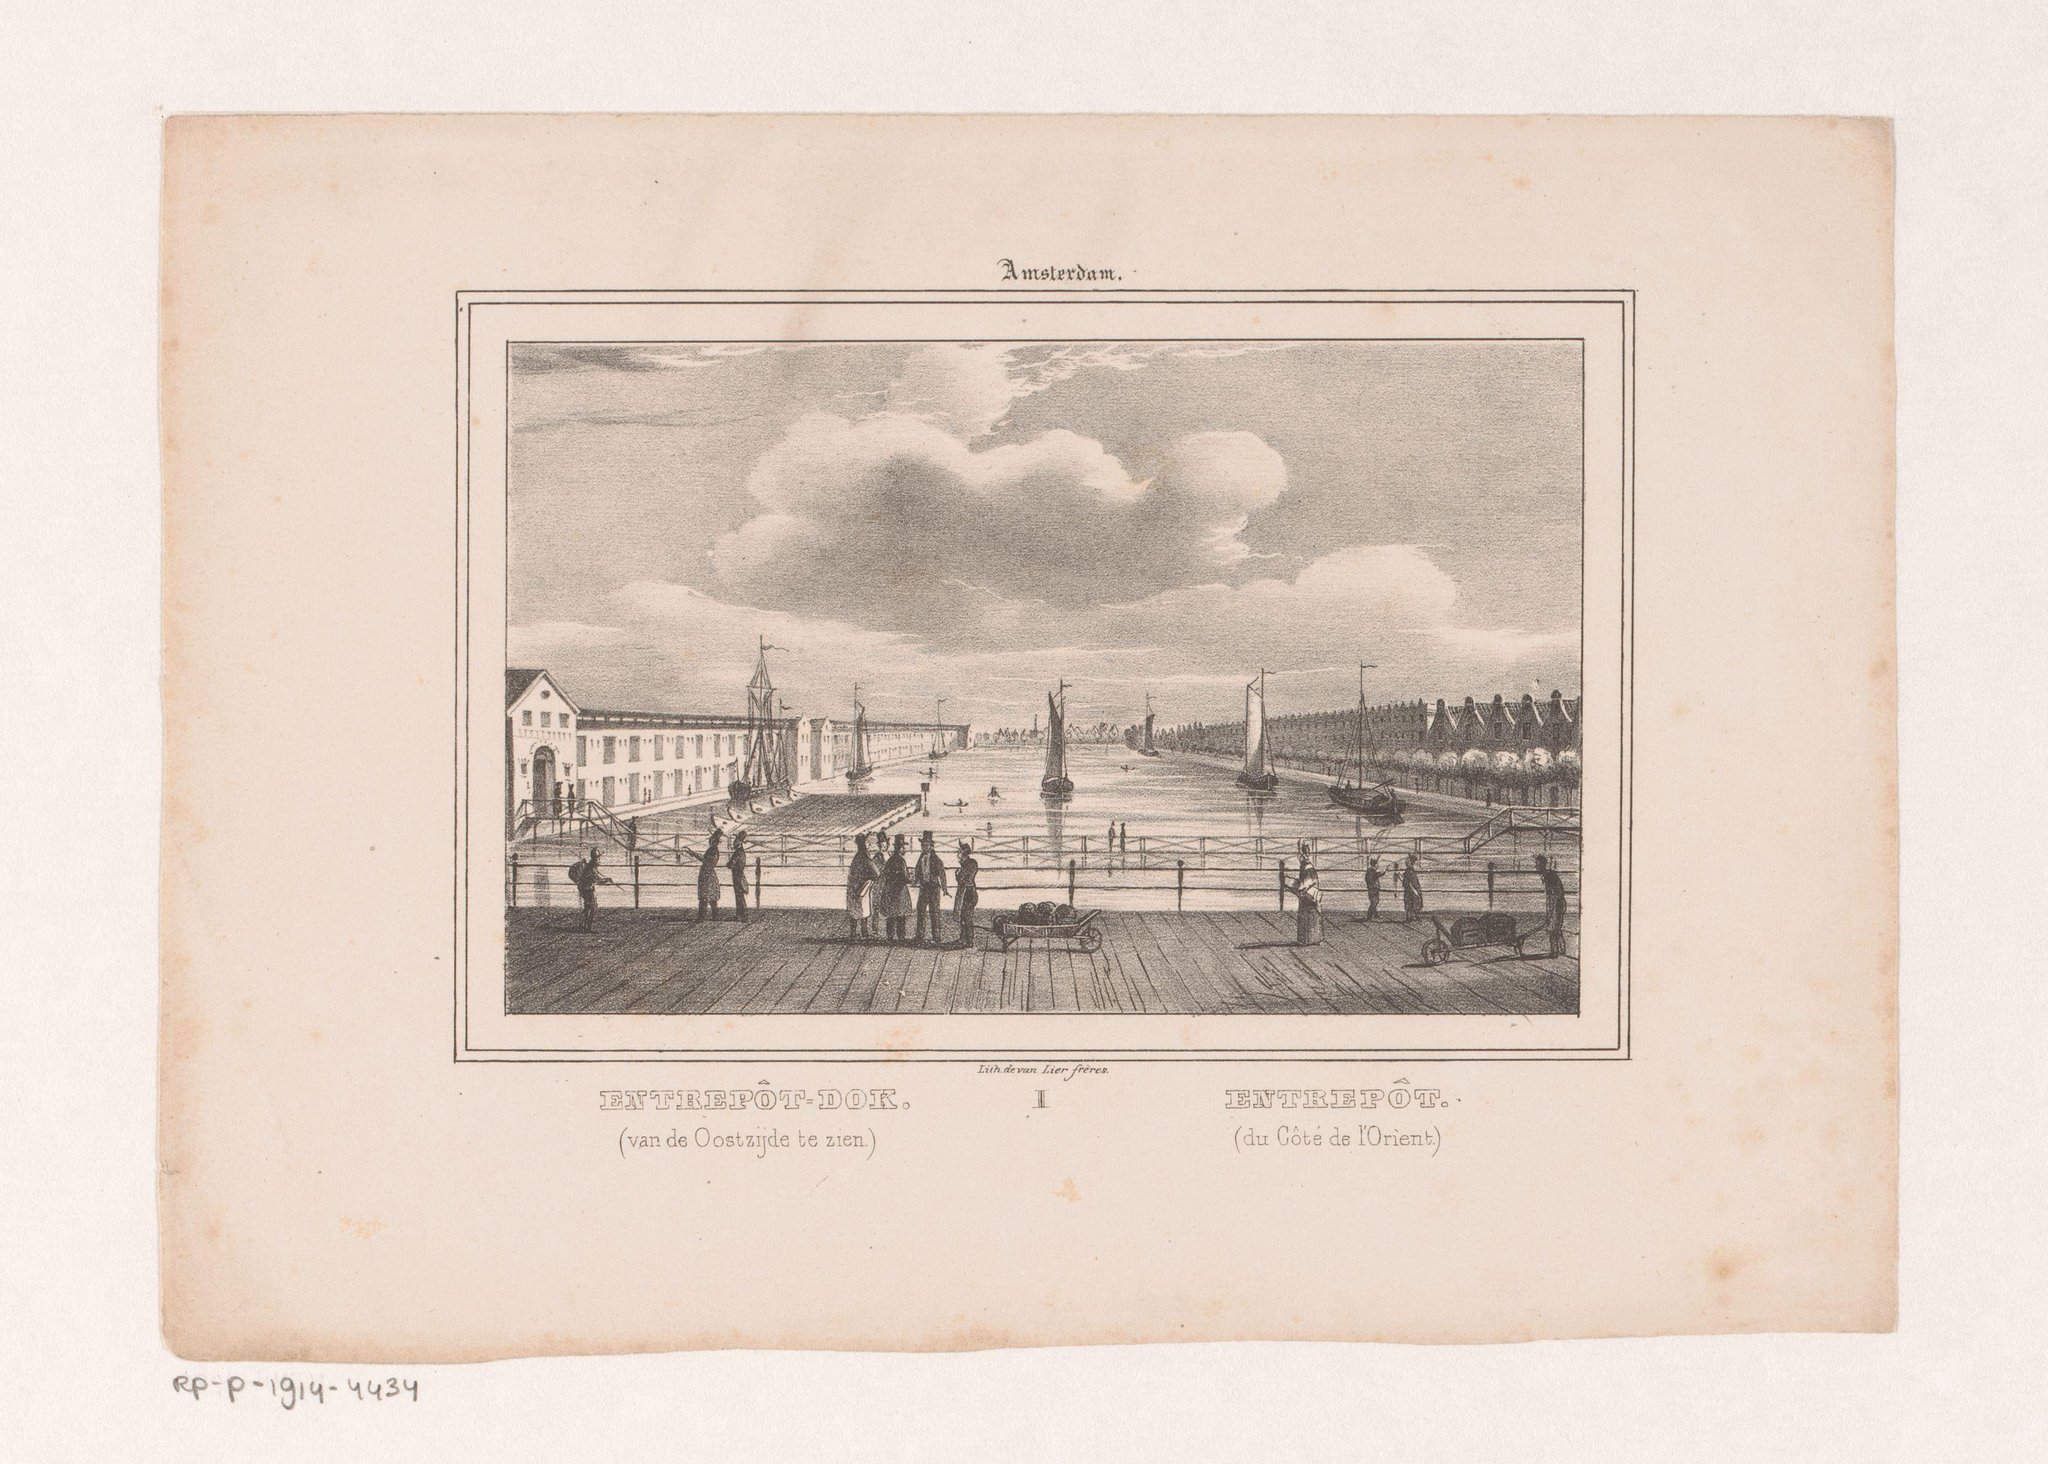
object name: print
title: Gezicht vanaf een brug bij het Entrepotdok in Amsterdam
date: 1833-1850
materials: paper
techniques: lithograph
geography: the hague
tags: warehouse (~ harbour), canals, waters (in city)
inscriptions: collector's mark: Lugt 2228